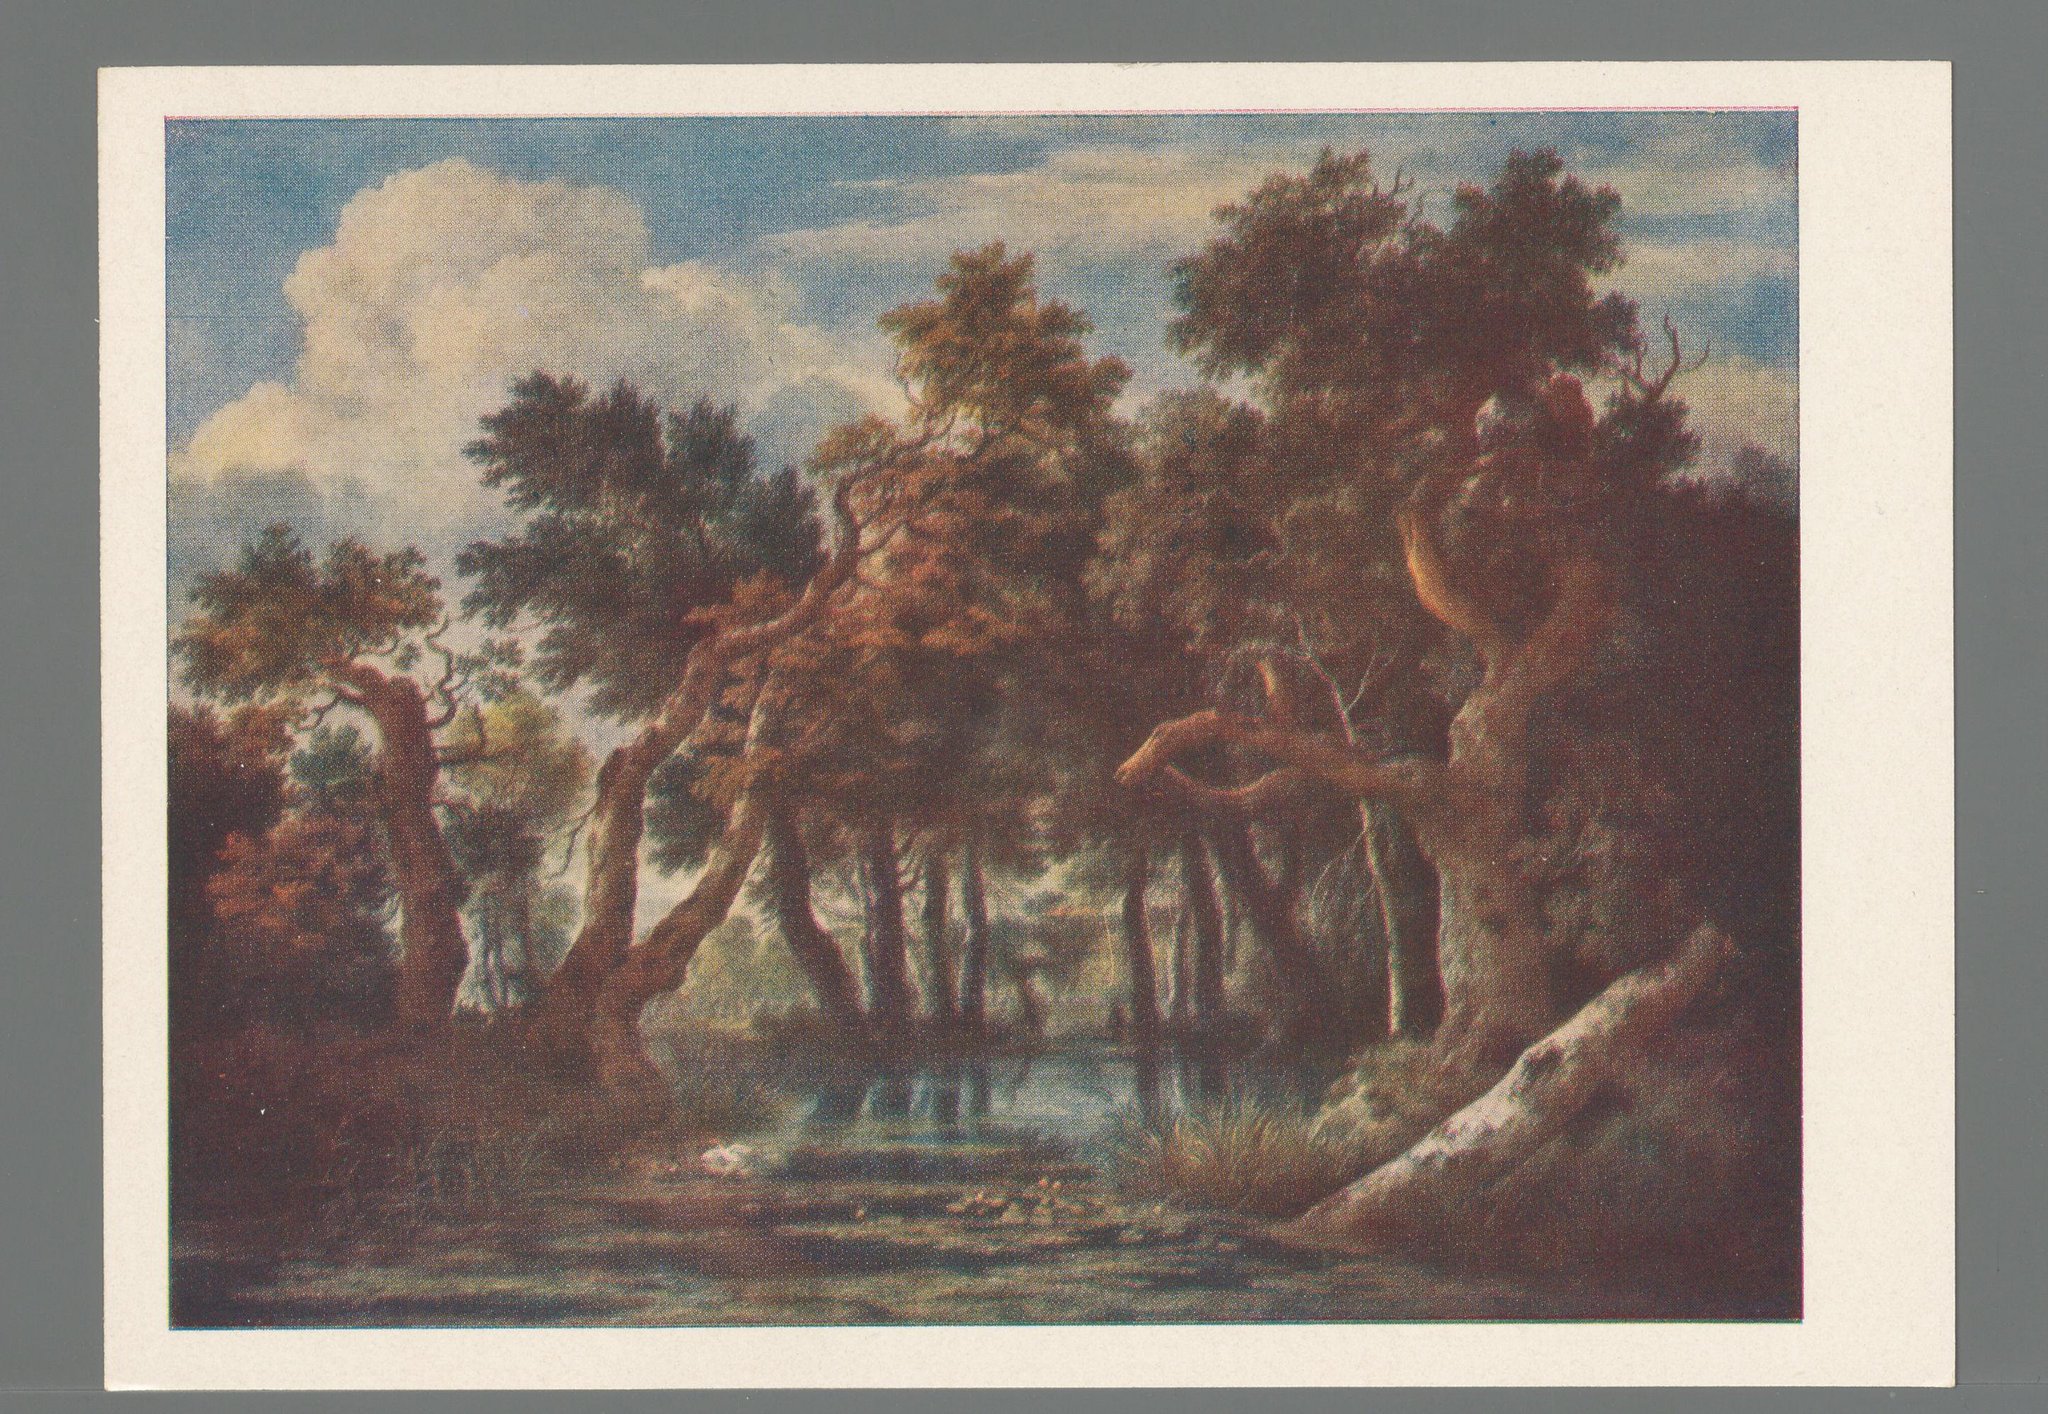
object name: photomechanical print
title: Jacob van Ruysdael - Moeras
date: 1959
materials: cardboard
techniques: color autotype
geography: moscow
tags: permanent exhibition, museum, picture, painting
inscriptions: date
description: De titel op object staat in het Russisch.